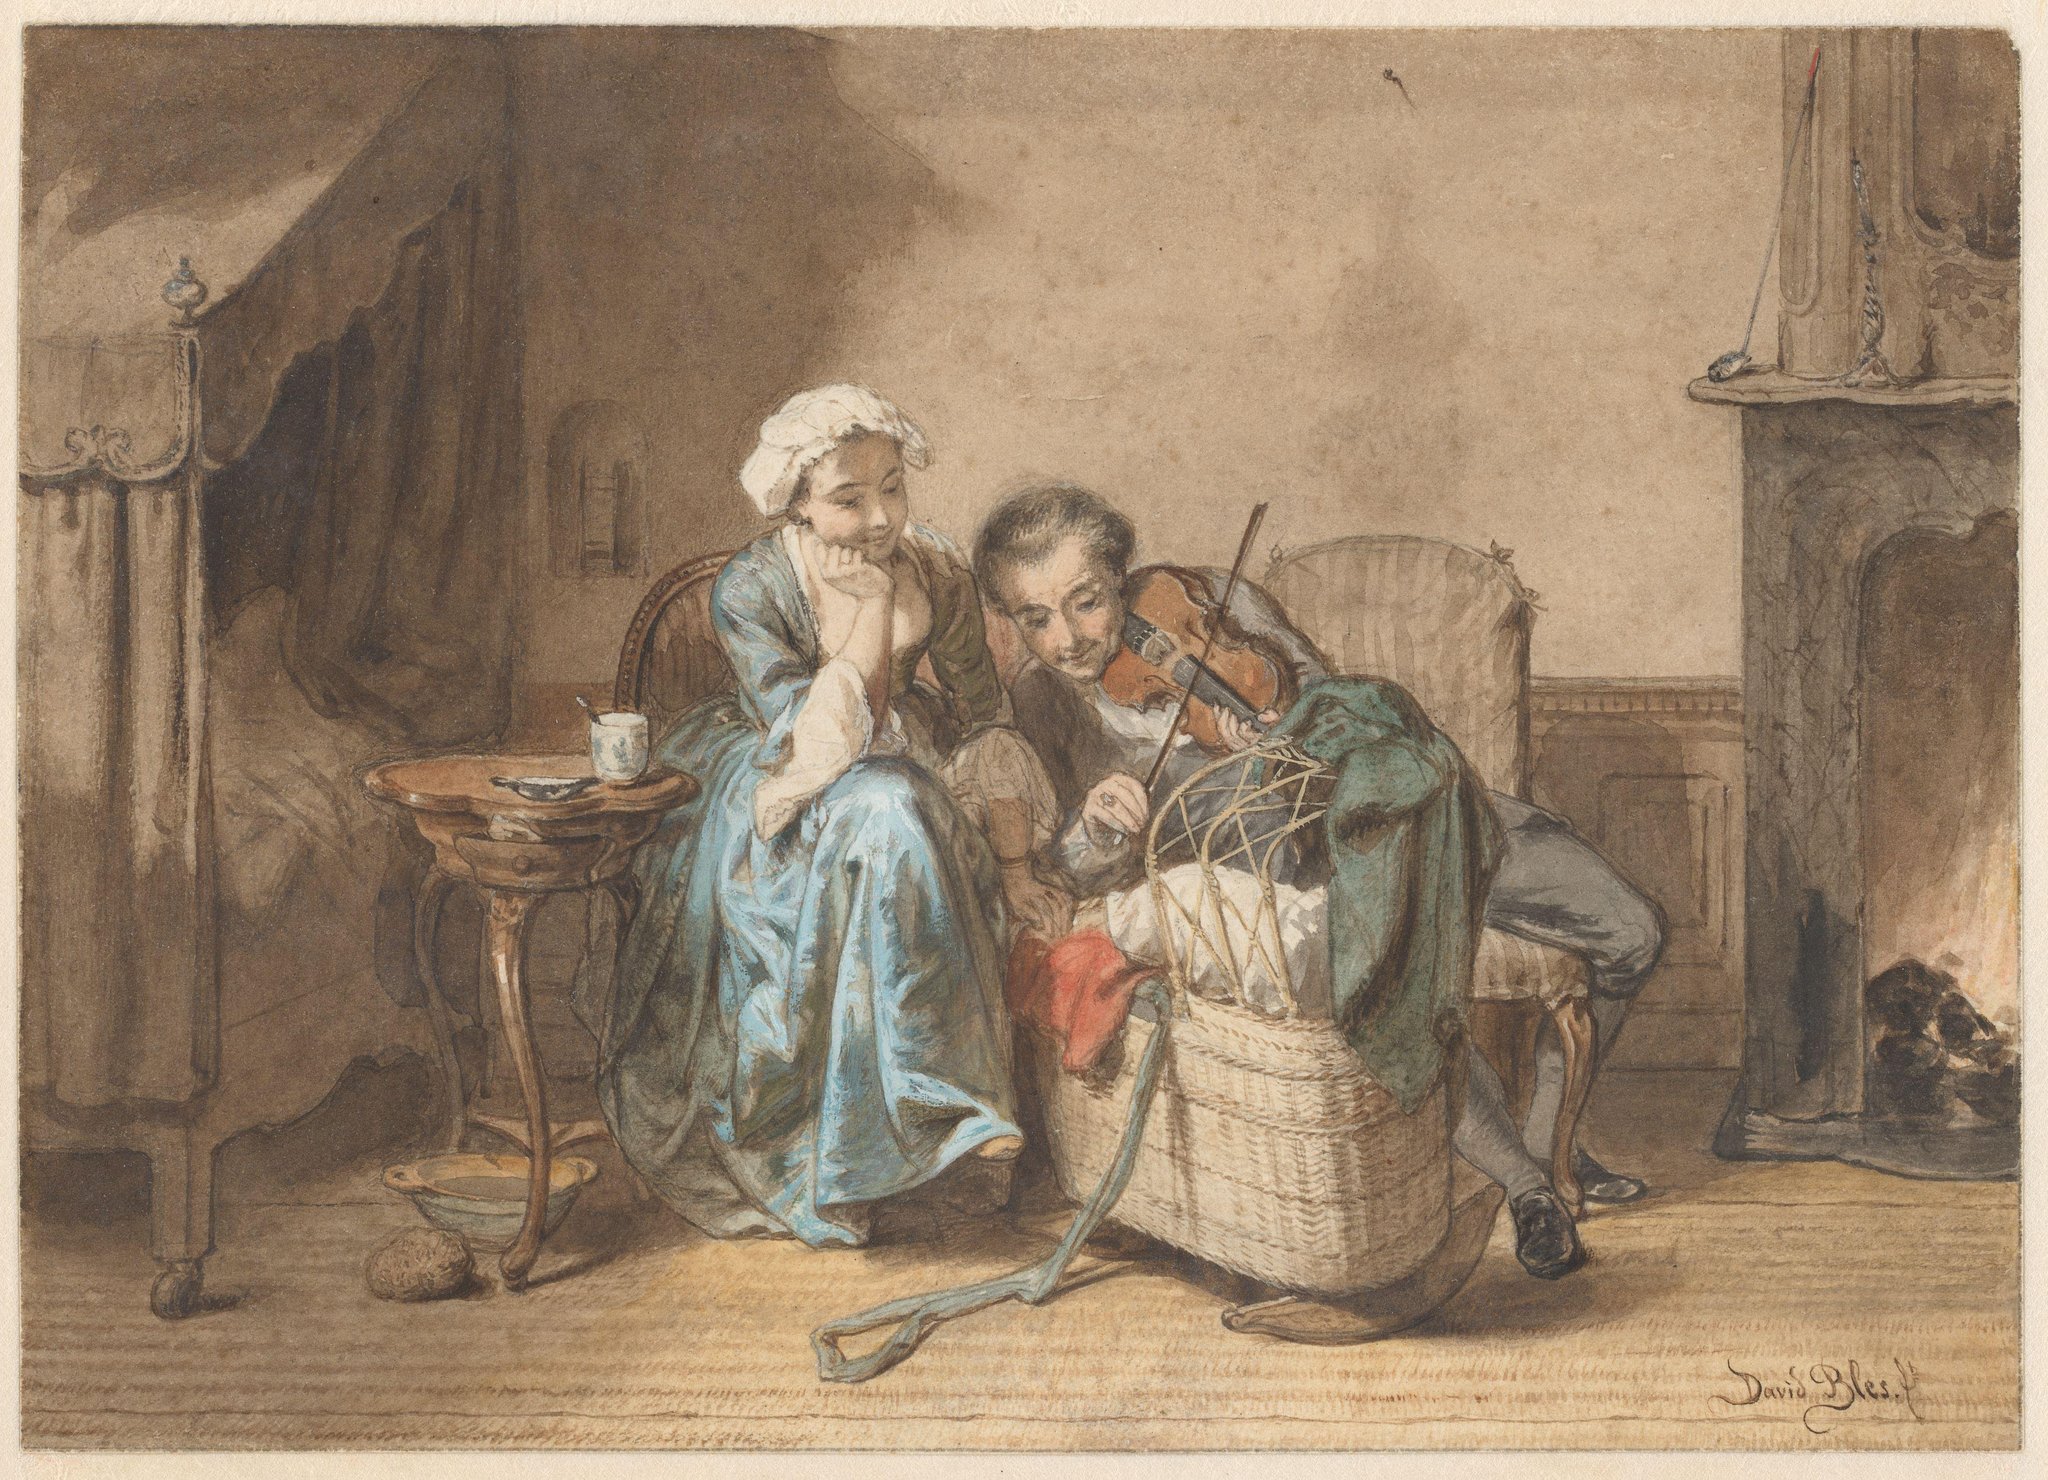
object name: drawing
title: Familiegeluk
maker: david bles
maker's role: draughtsman, painter, print maker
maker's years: 1821-1899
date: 1831-1899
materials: paper, pencil, watercolor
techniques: brush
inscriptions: signature: ‘David Bles ft.’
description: In: Krabbels en kapitale tekeningen, nr. 29, e.v. lit./ tent.